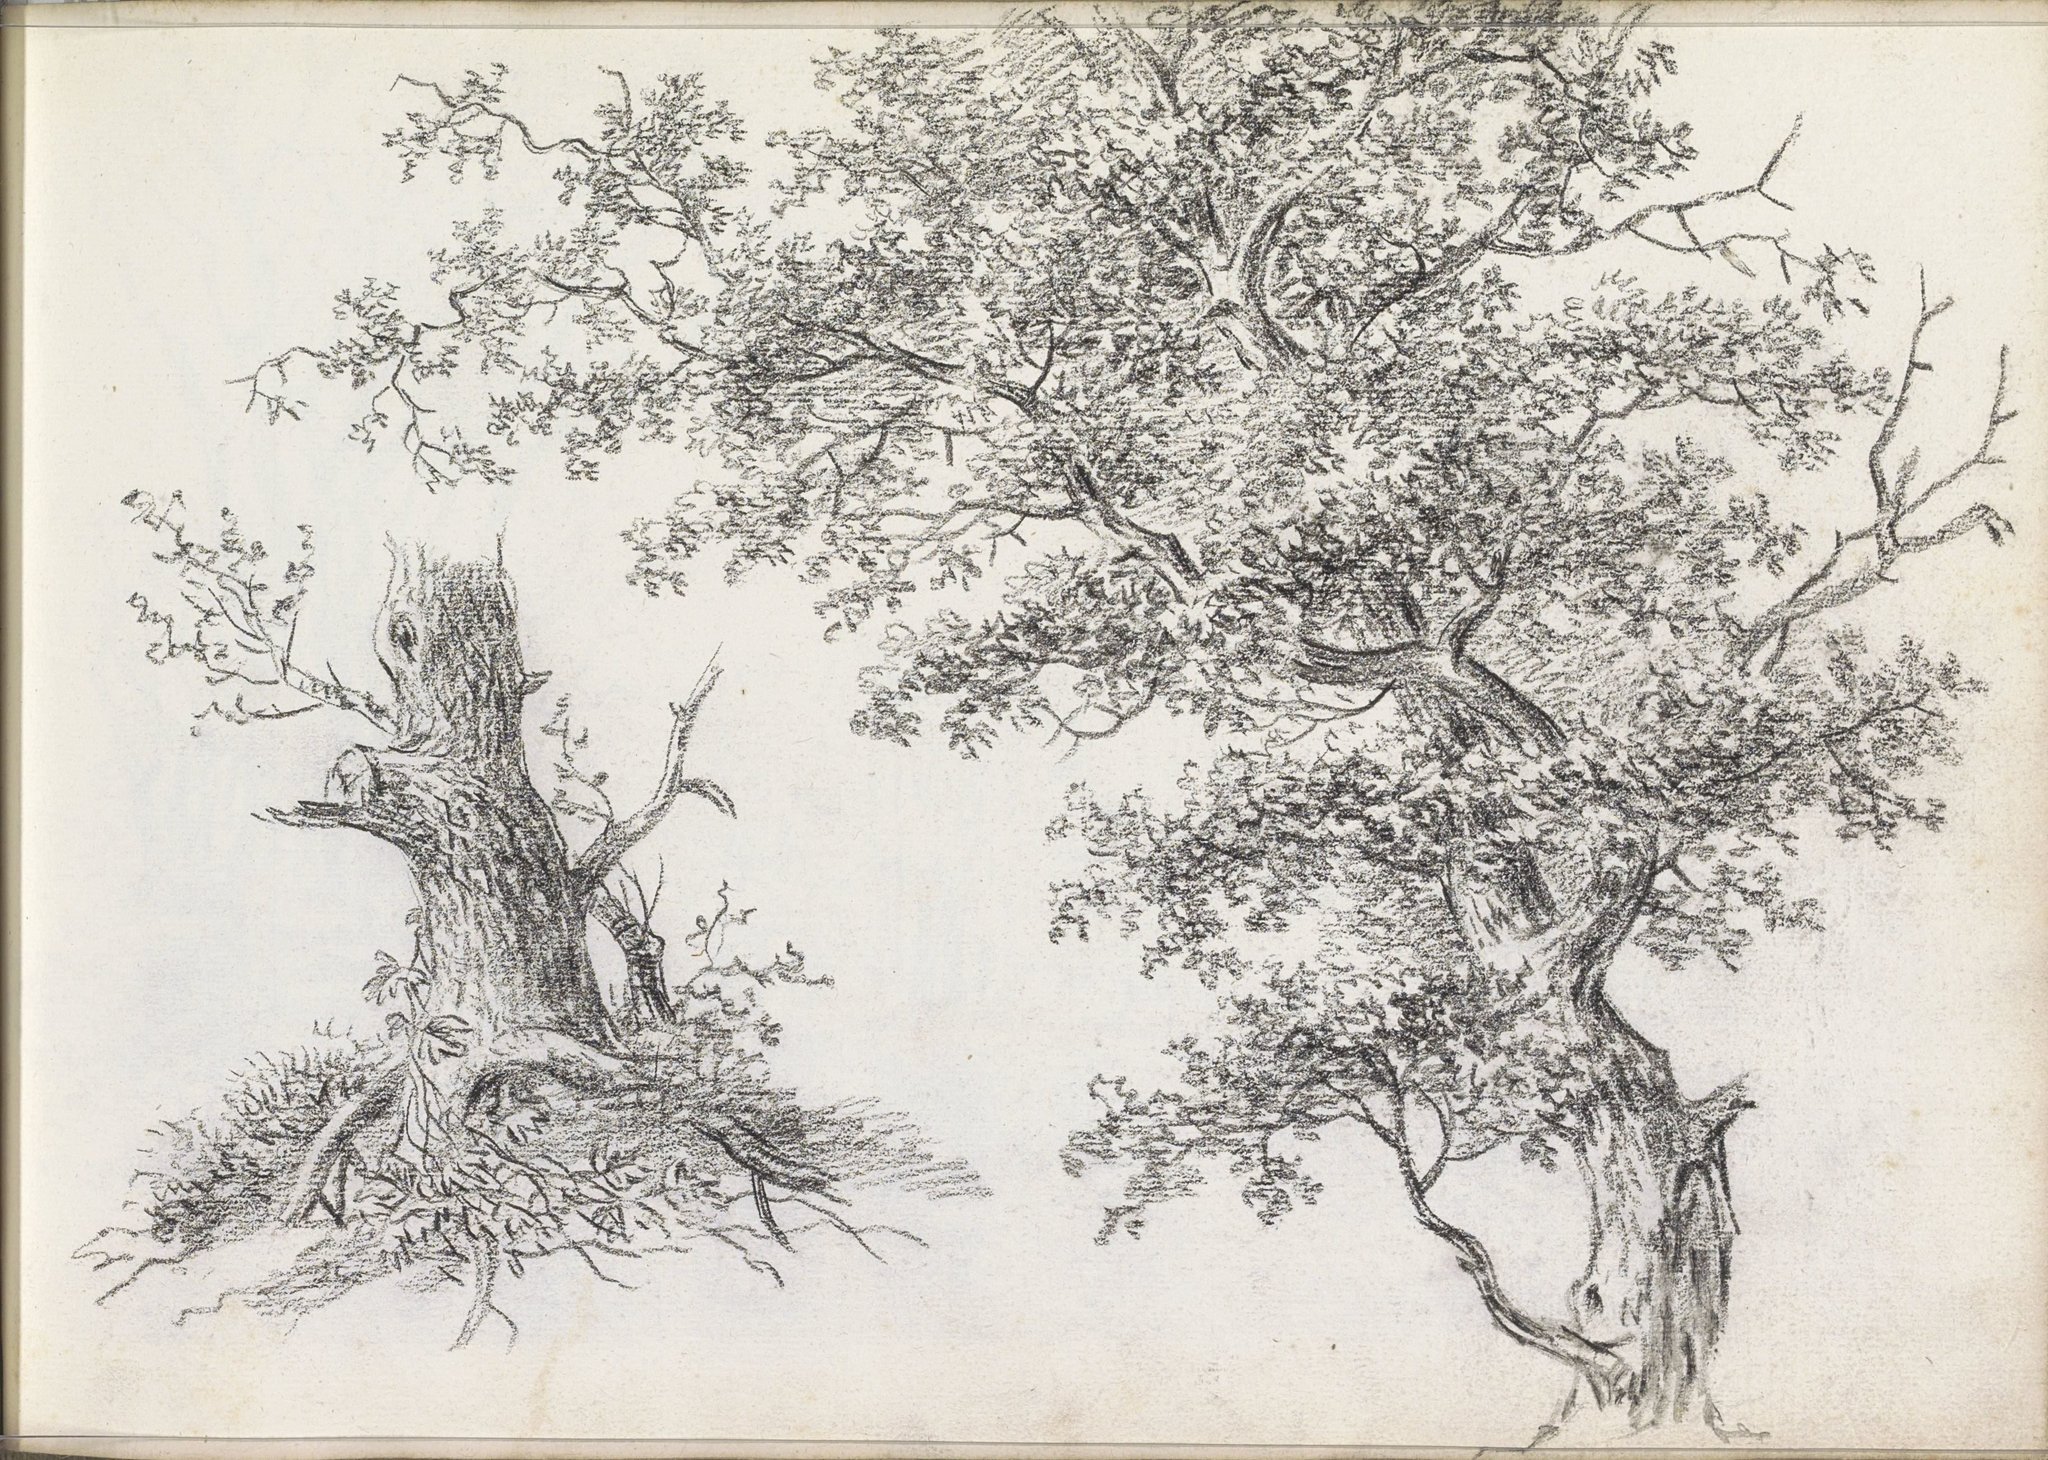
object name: sketchbook leaf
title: Stam, wortels en takken van een boom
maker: andreas schelfhout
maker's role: draughtsman, painter, print maker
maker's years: 1787-1870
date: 1811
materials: chalk, paper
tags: trees (+ root, tuber), trees (+ stem, trunk)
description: Blad 38 recto uit een schetsboek met 75 bladen.